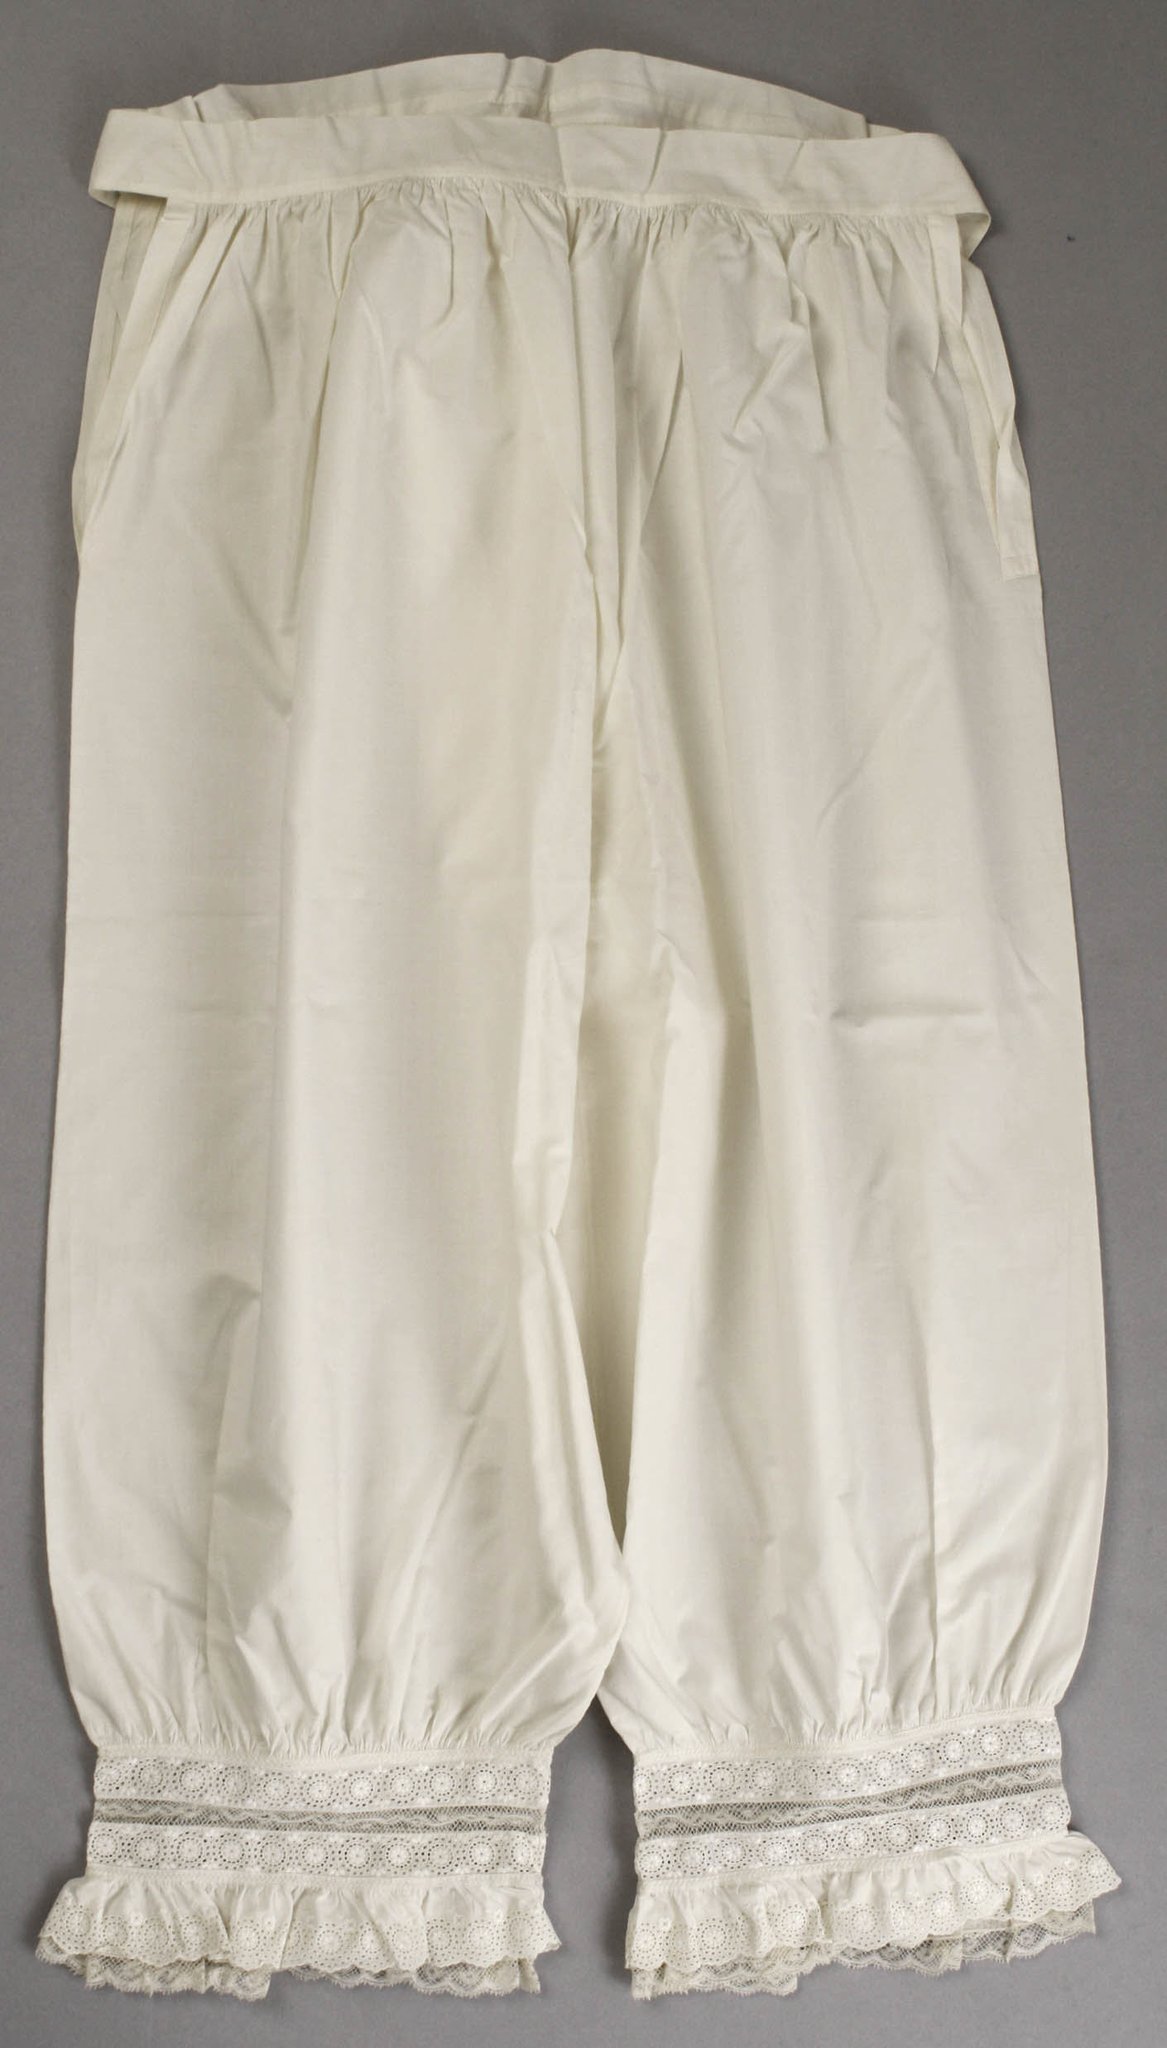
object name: drawer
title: Drawers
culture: american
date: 1880-1889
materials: cotton